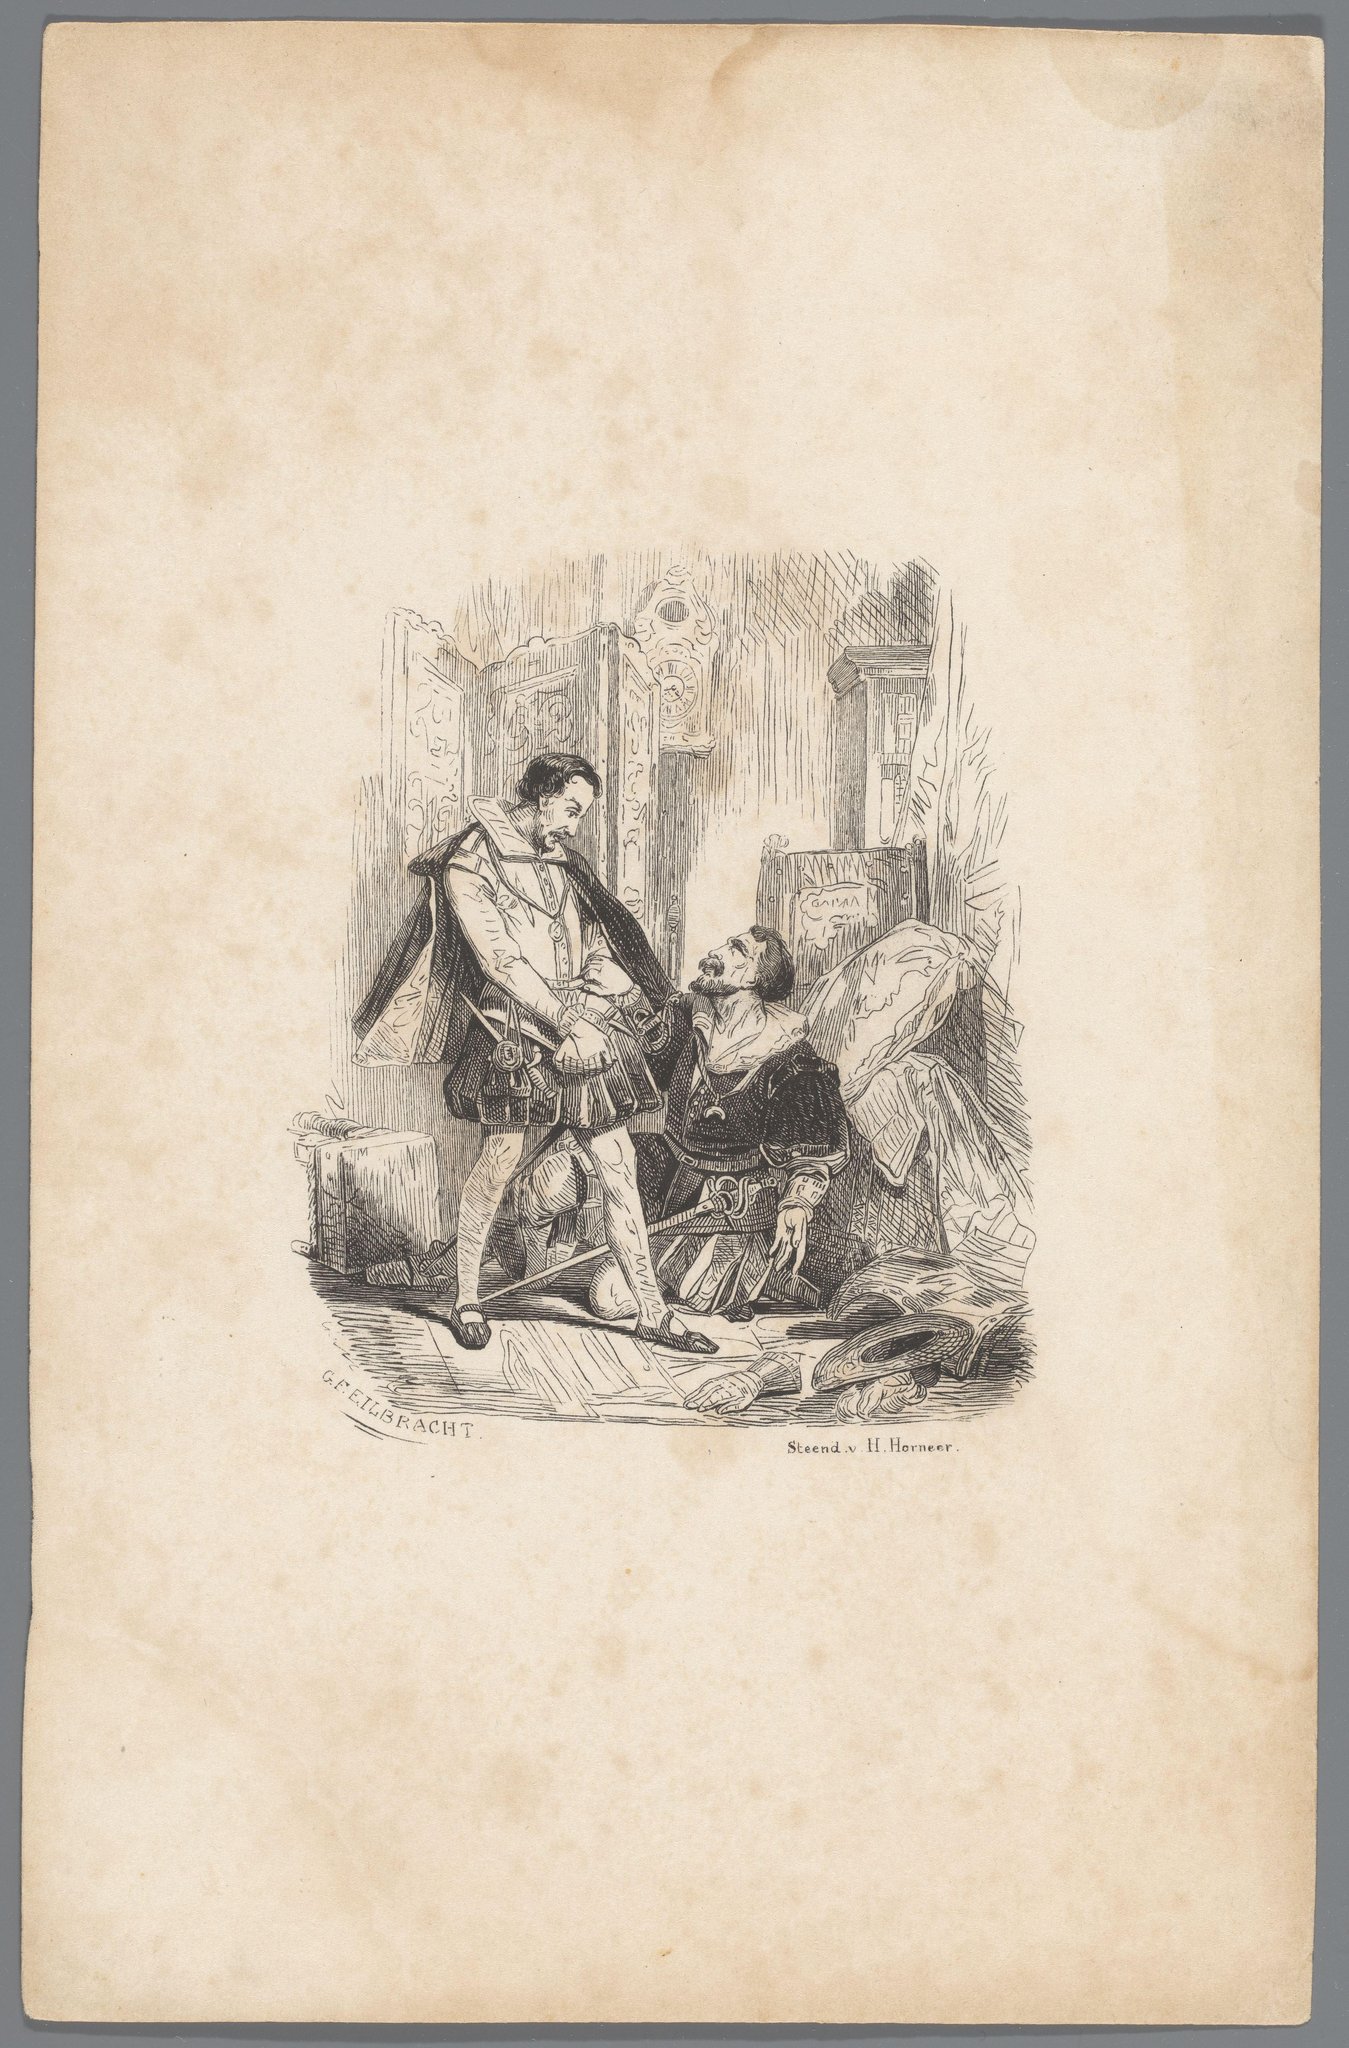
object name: print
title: Twaalf platen naar de oorspronkelijke teekeningen van Nicaise de Keizer, in steen gebragt door G.F. Eilbracht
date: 1844-1854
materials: paper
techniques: lithograph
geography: netherlands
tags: (scenes from) specific works of literature (with author, title), interior of the house, kneeling on both knees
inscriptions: collector's mark: Lugt 2228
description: Interieur waarin een man knielt voor een andere man. Los blad in een mapje met twaalf lithografieën naar de houtgravures gebruikt als illustraties in: Félix Bogaerts, El Maestro del Campo, 1839.